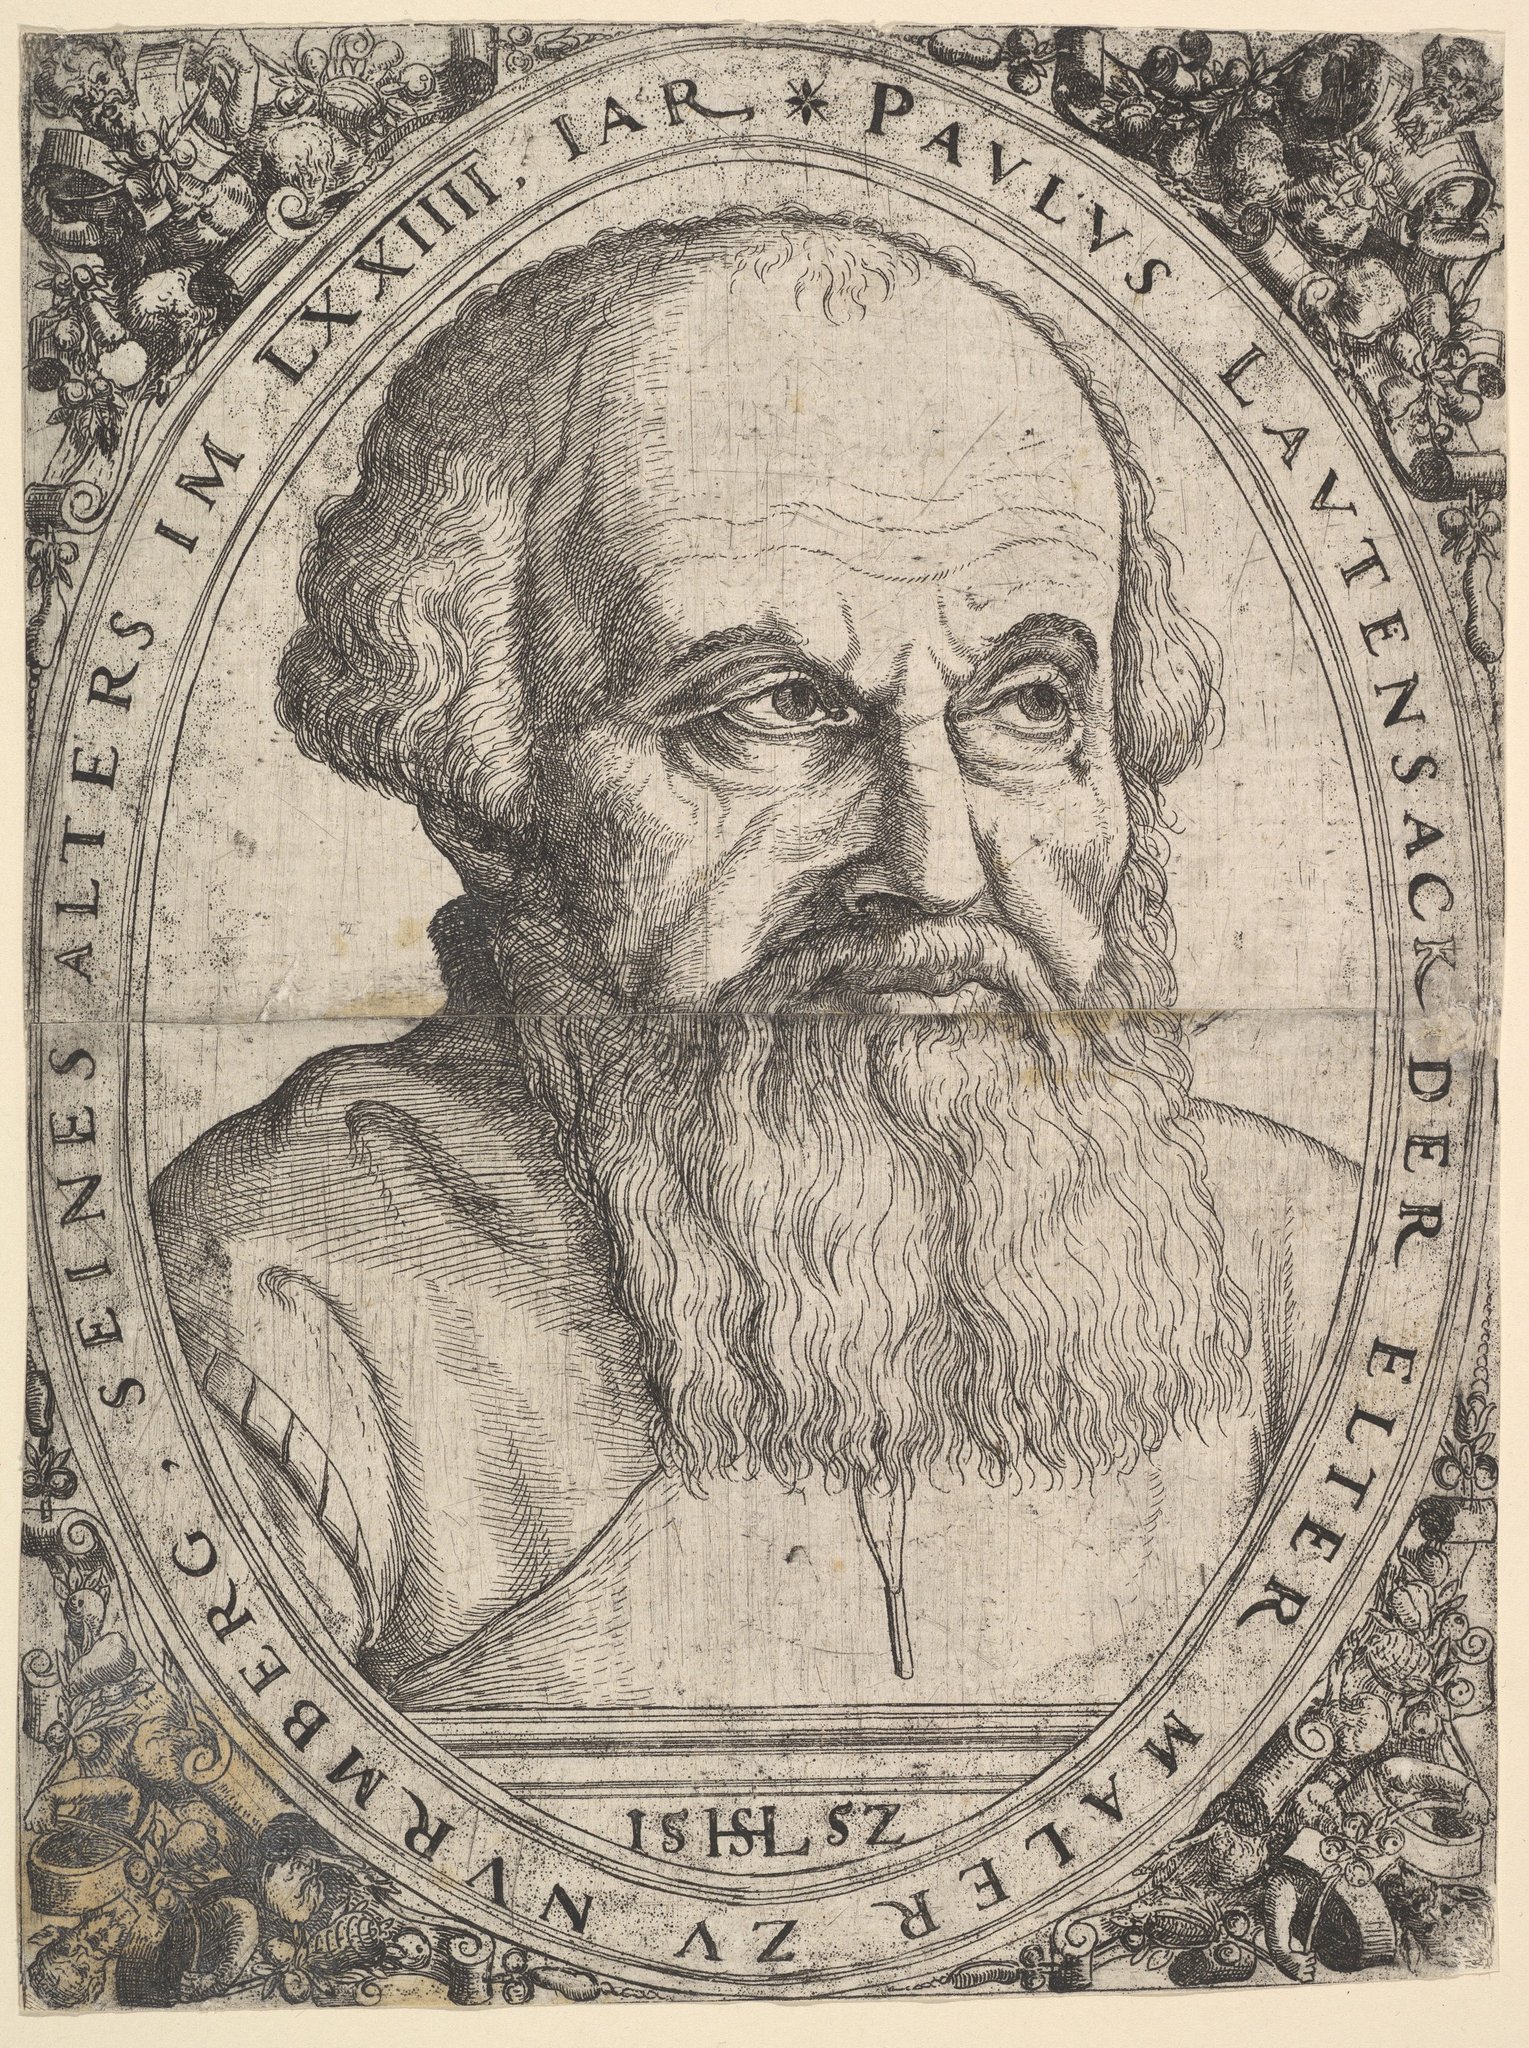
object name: print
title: Portrait of Paulus Lautensack the Elder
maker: hanns lautensack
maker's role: artist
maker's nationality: german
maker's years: 1515-1566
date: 1552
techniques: etching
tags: men,portraits